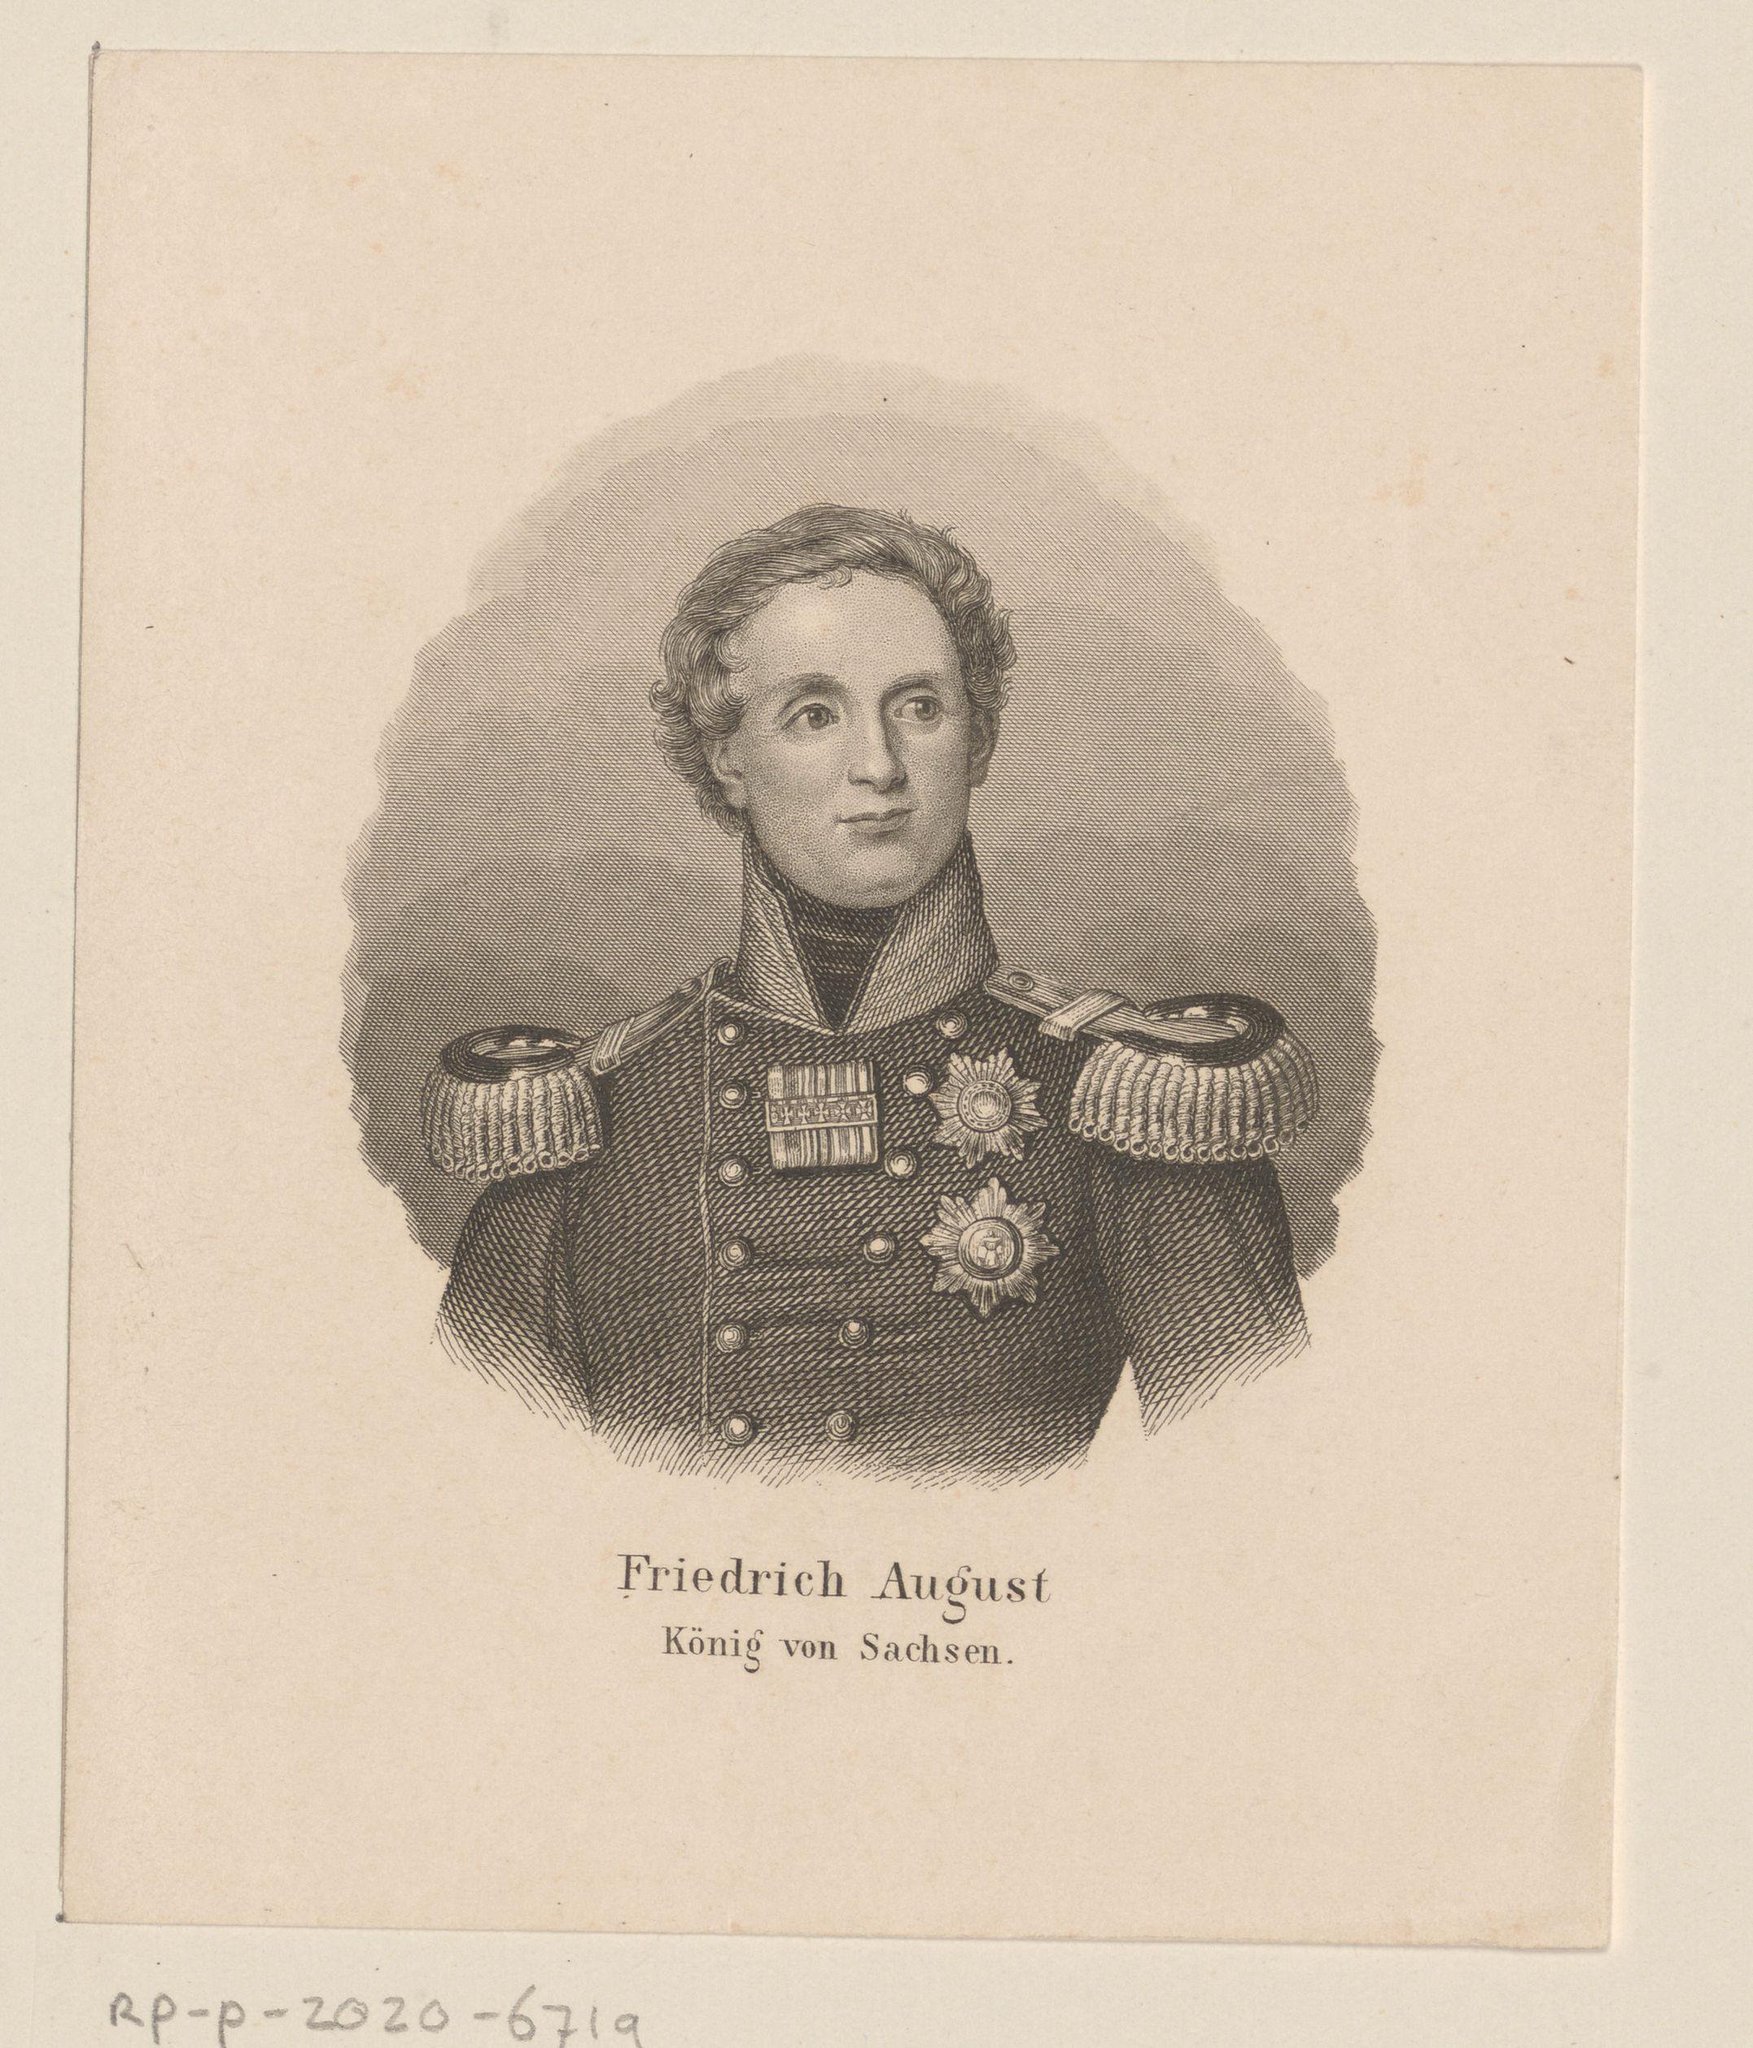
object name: print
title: Portret van Frederik August II van Saksen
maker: Anonymous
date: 1836-1880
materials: paper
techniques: engraving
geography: germany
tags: historical persons, (military) uniforms, king